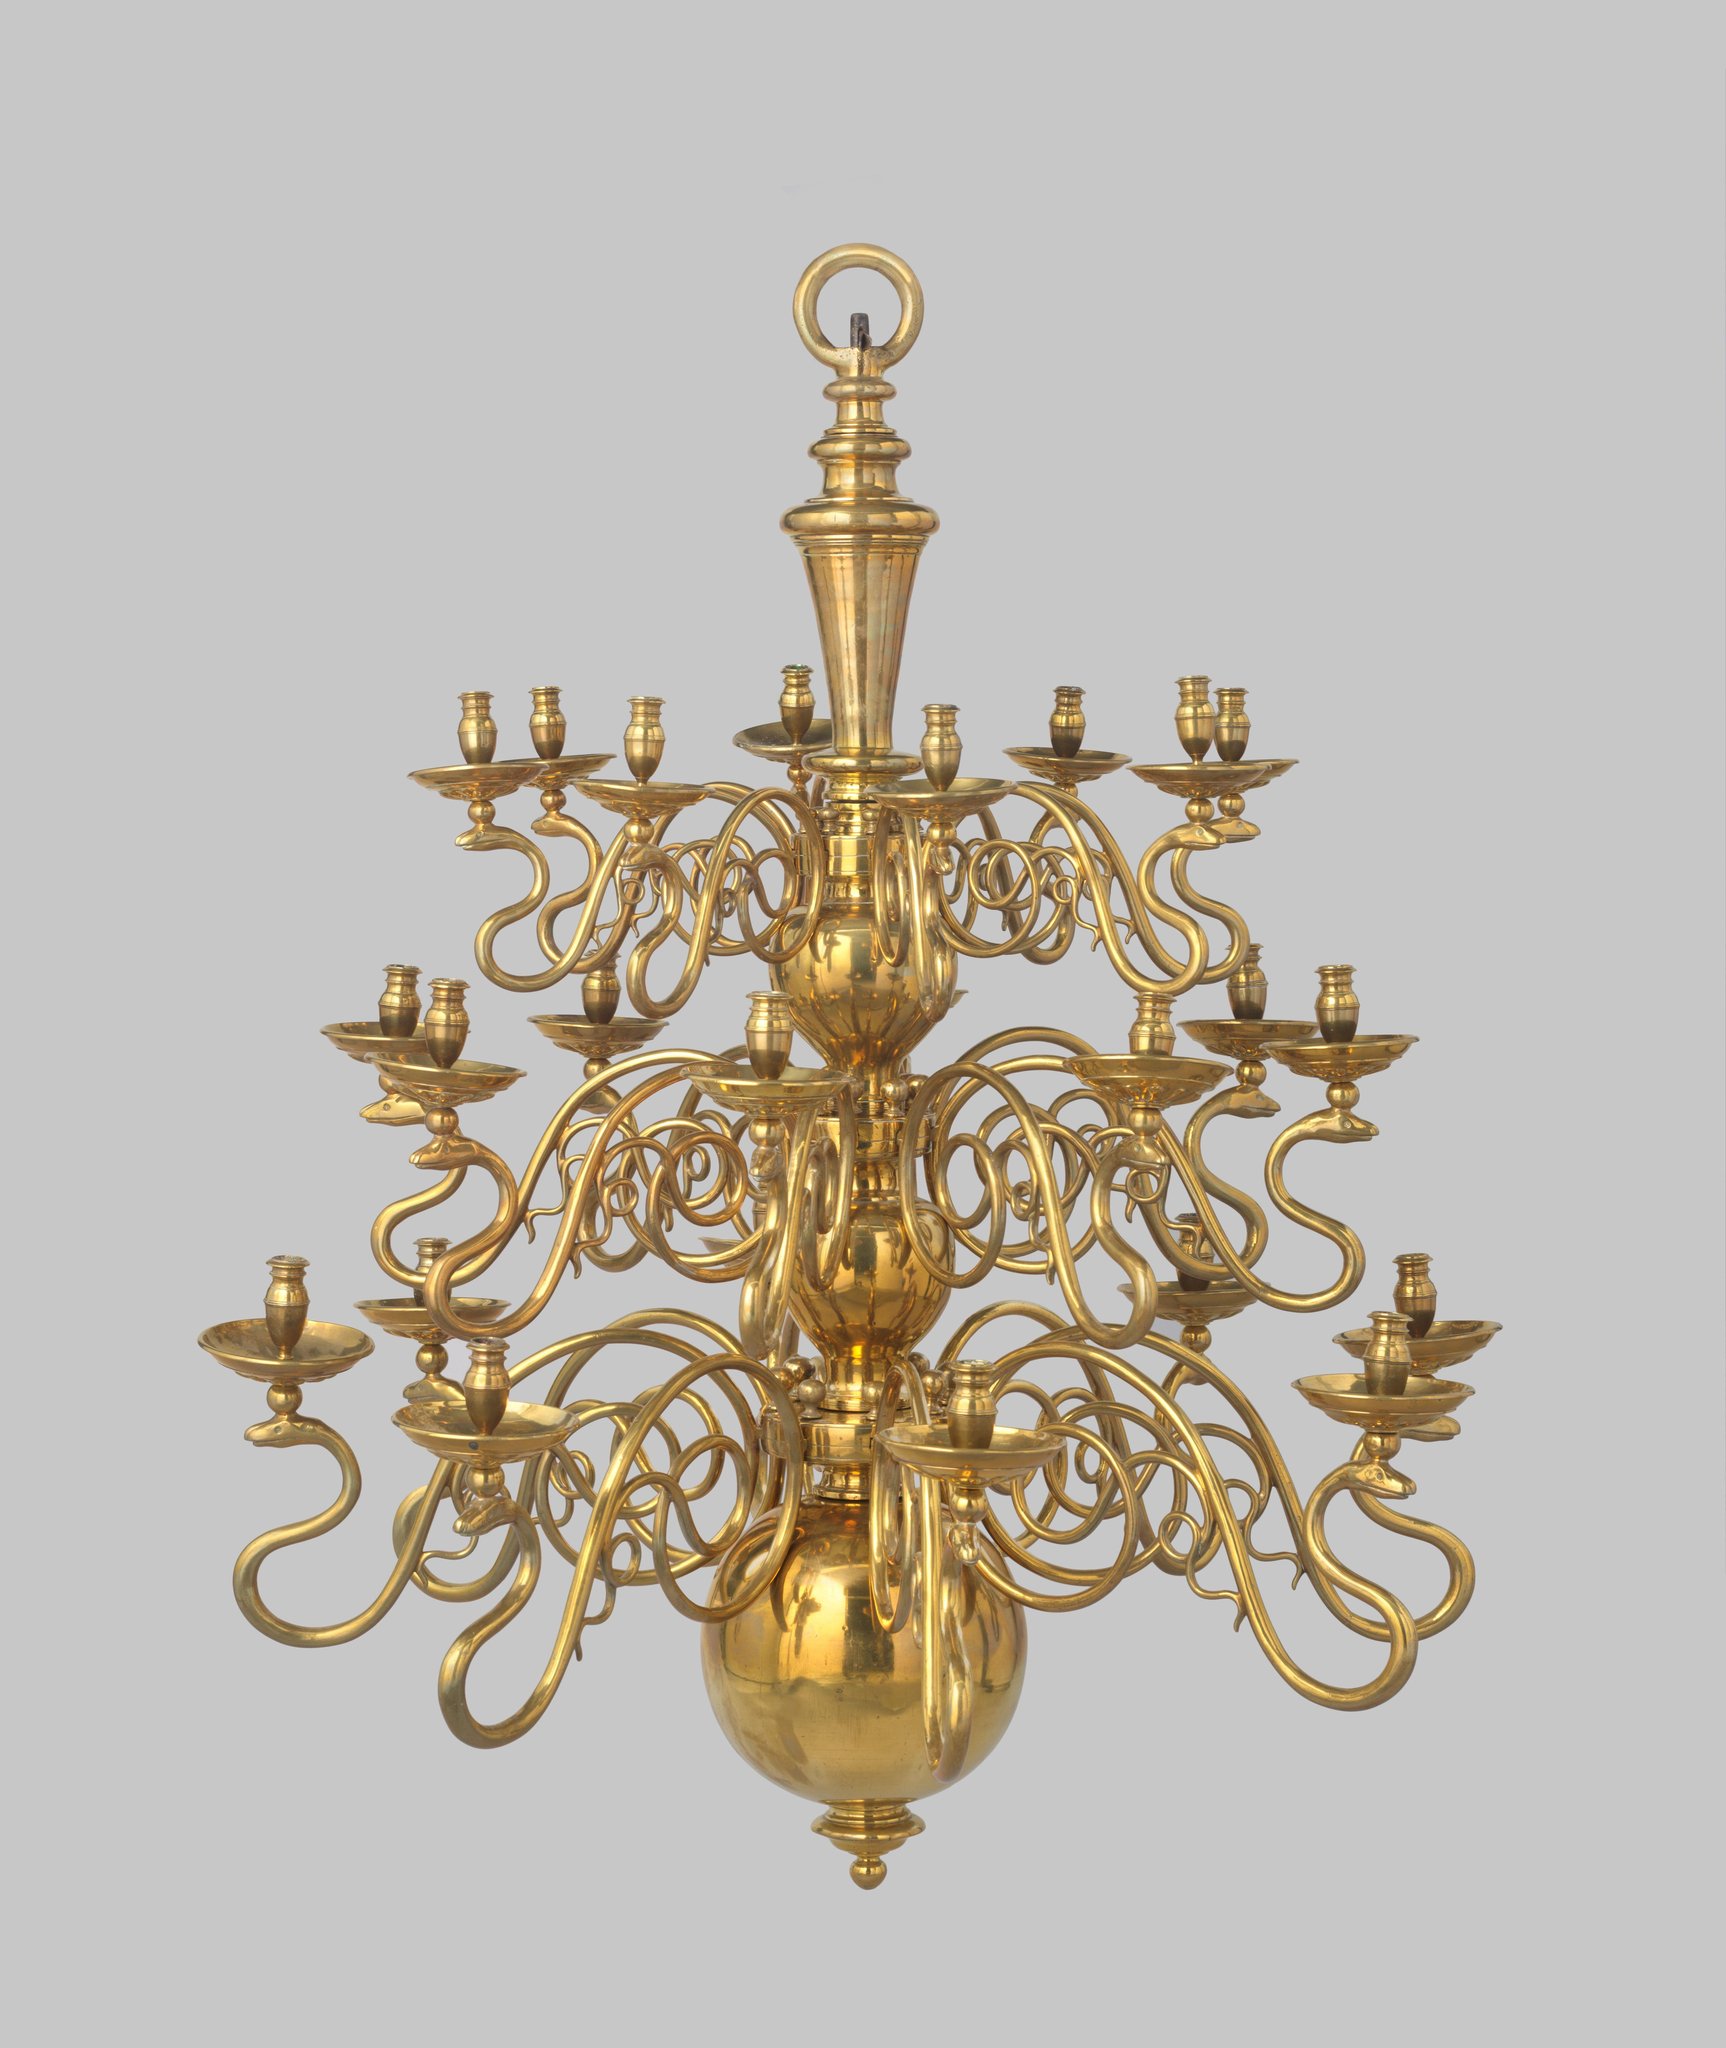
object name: chandelier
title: Arm van een kaarsenkroon in drie hoogten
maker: Anonymous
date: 1625-1650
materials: brass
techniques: casting, screwed, turning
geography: northern netherlands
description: De arm is aan de stamzijde voorzien van een nok, waarin een gat is aangebracht om ze met een pin in de standringen te kunnen vastzetten. De S-vormige arm heeft de gedaante van een slang met een naar de stamzijde gekronkelde staart en naar buiten toe een opgeheven kop met daarop een ronde knop, waarin het van een schroefdraad voorziene gat is aangebracht ter bevestiging van de kaarsenhouders met de vetvangers. De arm is met behulp van hetzelfde model gegoten als de overige armen van de krans. De ronde kaarsenhouder is vaasvormig met een geprofileerde rib. Bovenaan heeft zij twee holronde profileringen, en een uitkragende rand en onderaan een uit twee holronde profileringen bestaande voet. De voet loopt uit in een zich verjongend schroefeind met een centergat. De bolle vetvanger is aan de bovenkant glad en heeft aan de onderkant visblaasachtige godrons en een rib. De vetvanger is met behulp van hetzelfde model gegoten als de overige vetvangers van de krans. De pinnen zijn met bolle knoppen versierd. Dit is de vierde arm van de bovenste standring, genummerd op de nok met het cijfer IV.